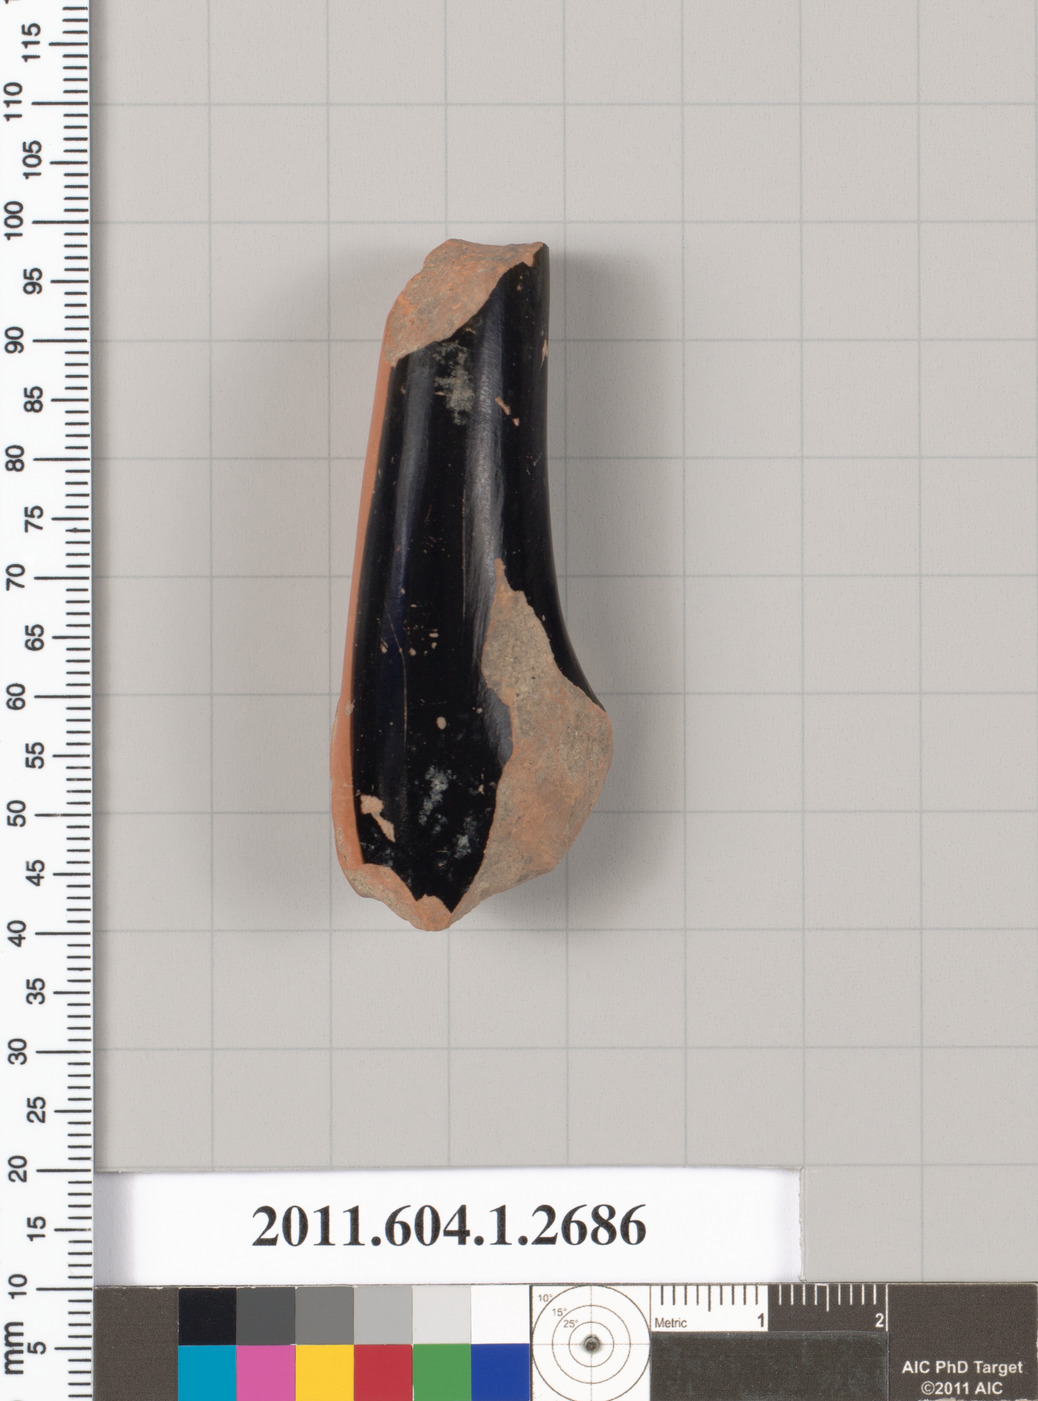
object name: kylix fragment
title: Terracotta fragment of a kylix (drinking cup)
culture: greek, attic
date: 500-451 BCE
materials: terracotta